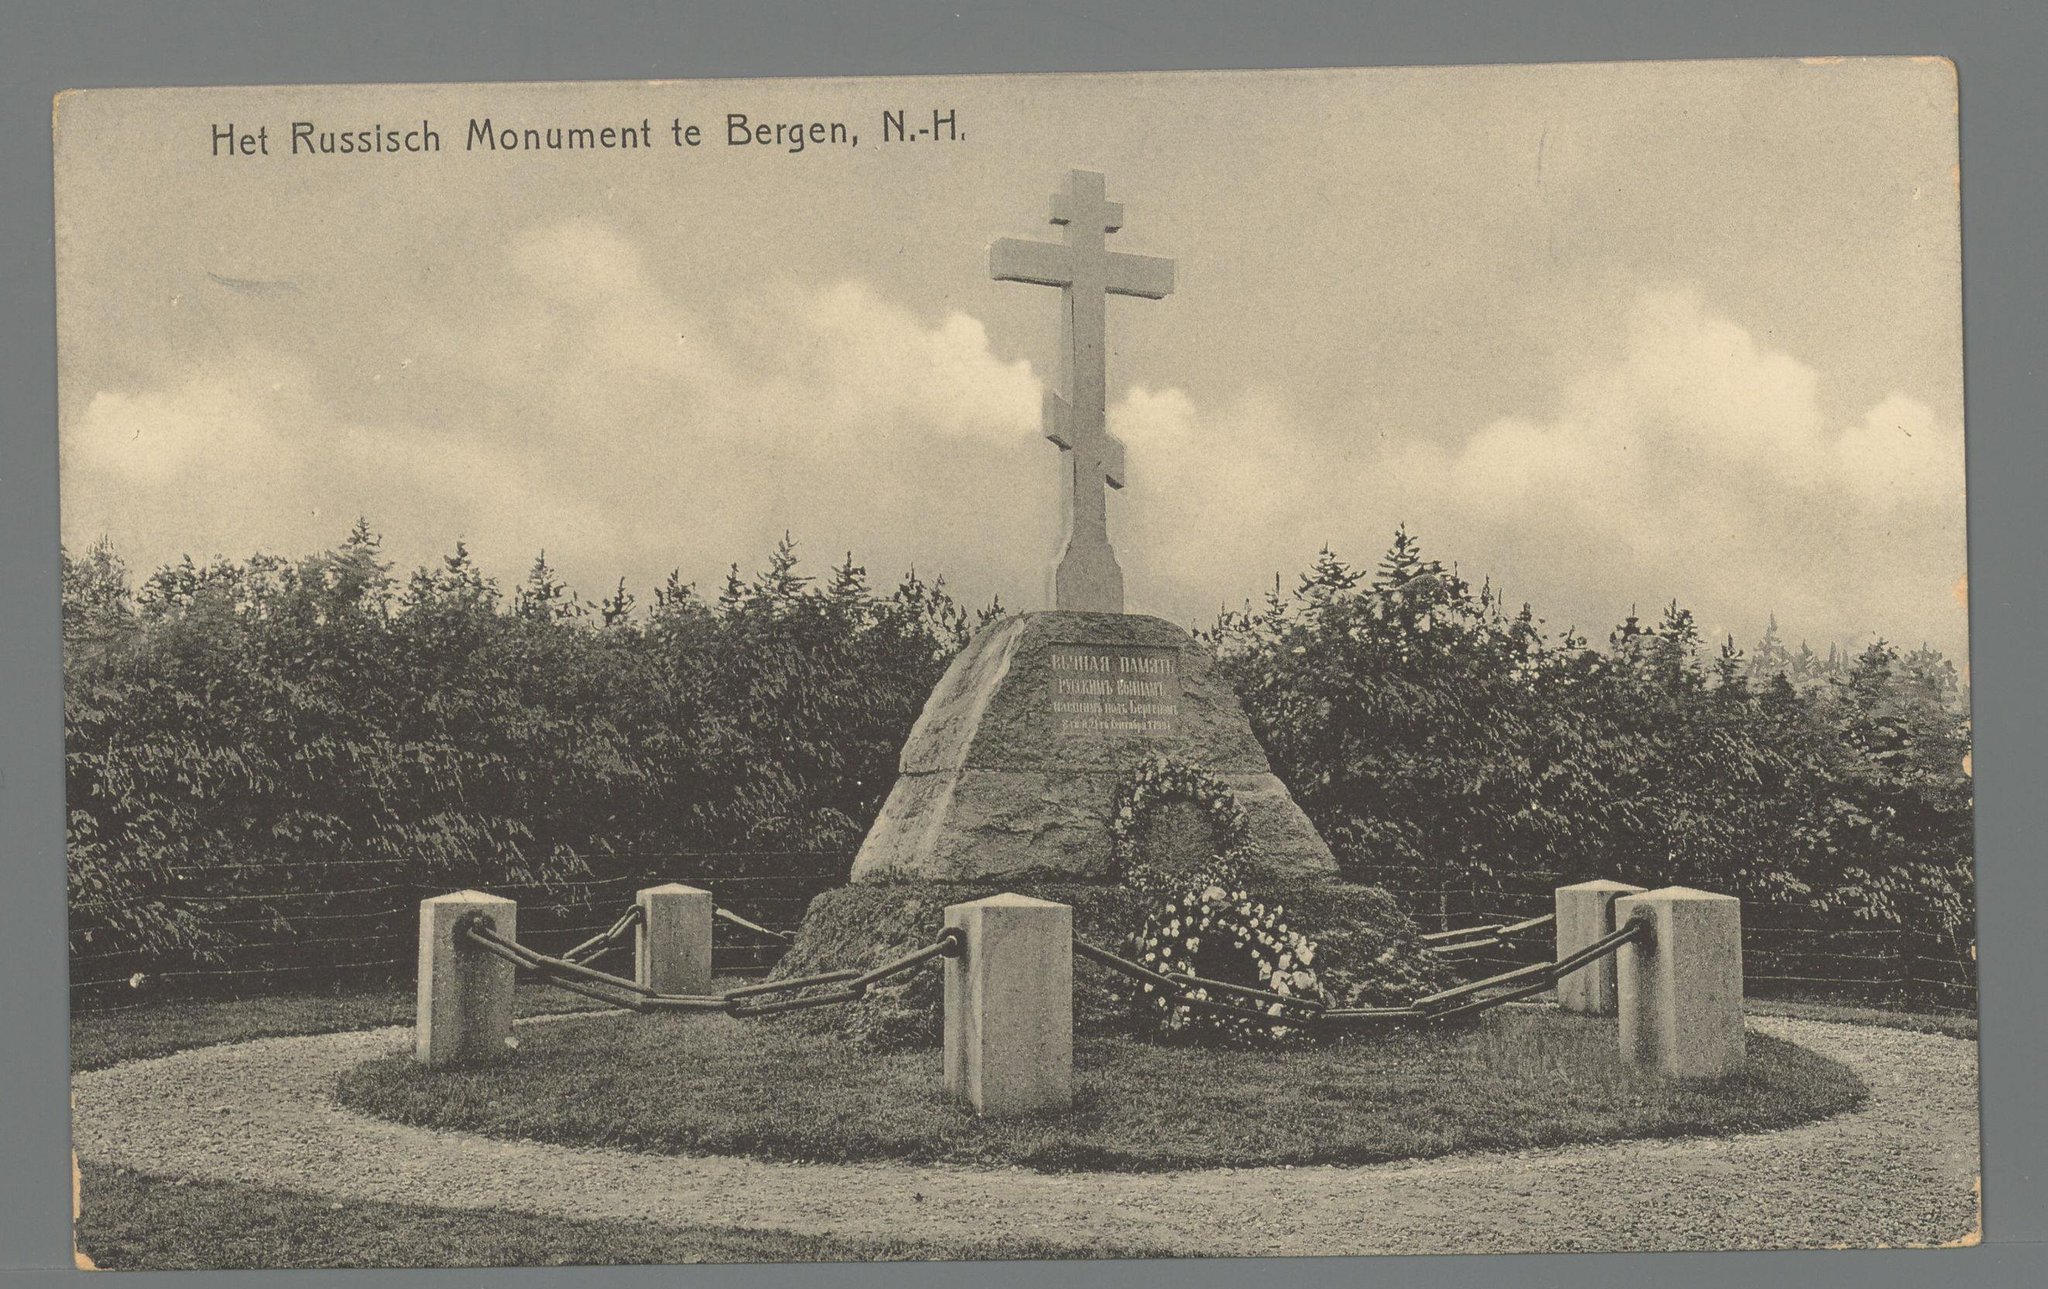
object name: ansichtkaart, prentbriefkaart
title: Het Russisch Monument te Bergen, N.-H.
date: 1905-1930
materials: cardboard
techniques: photograph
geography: bergen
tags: garland, wreath, monument, statue